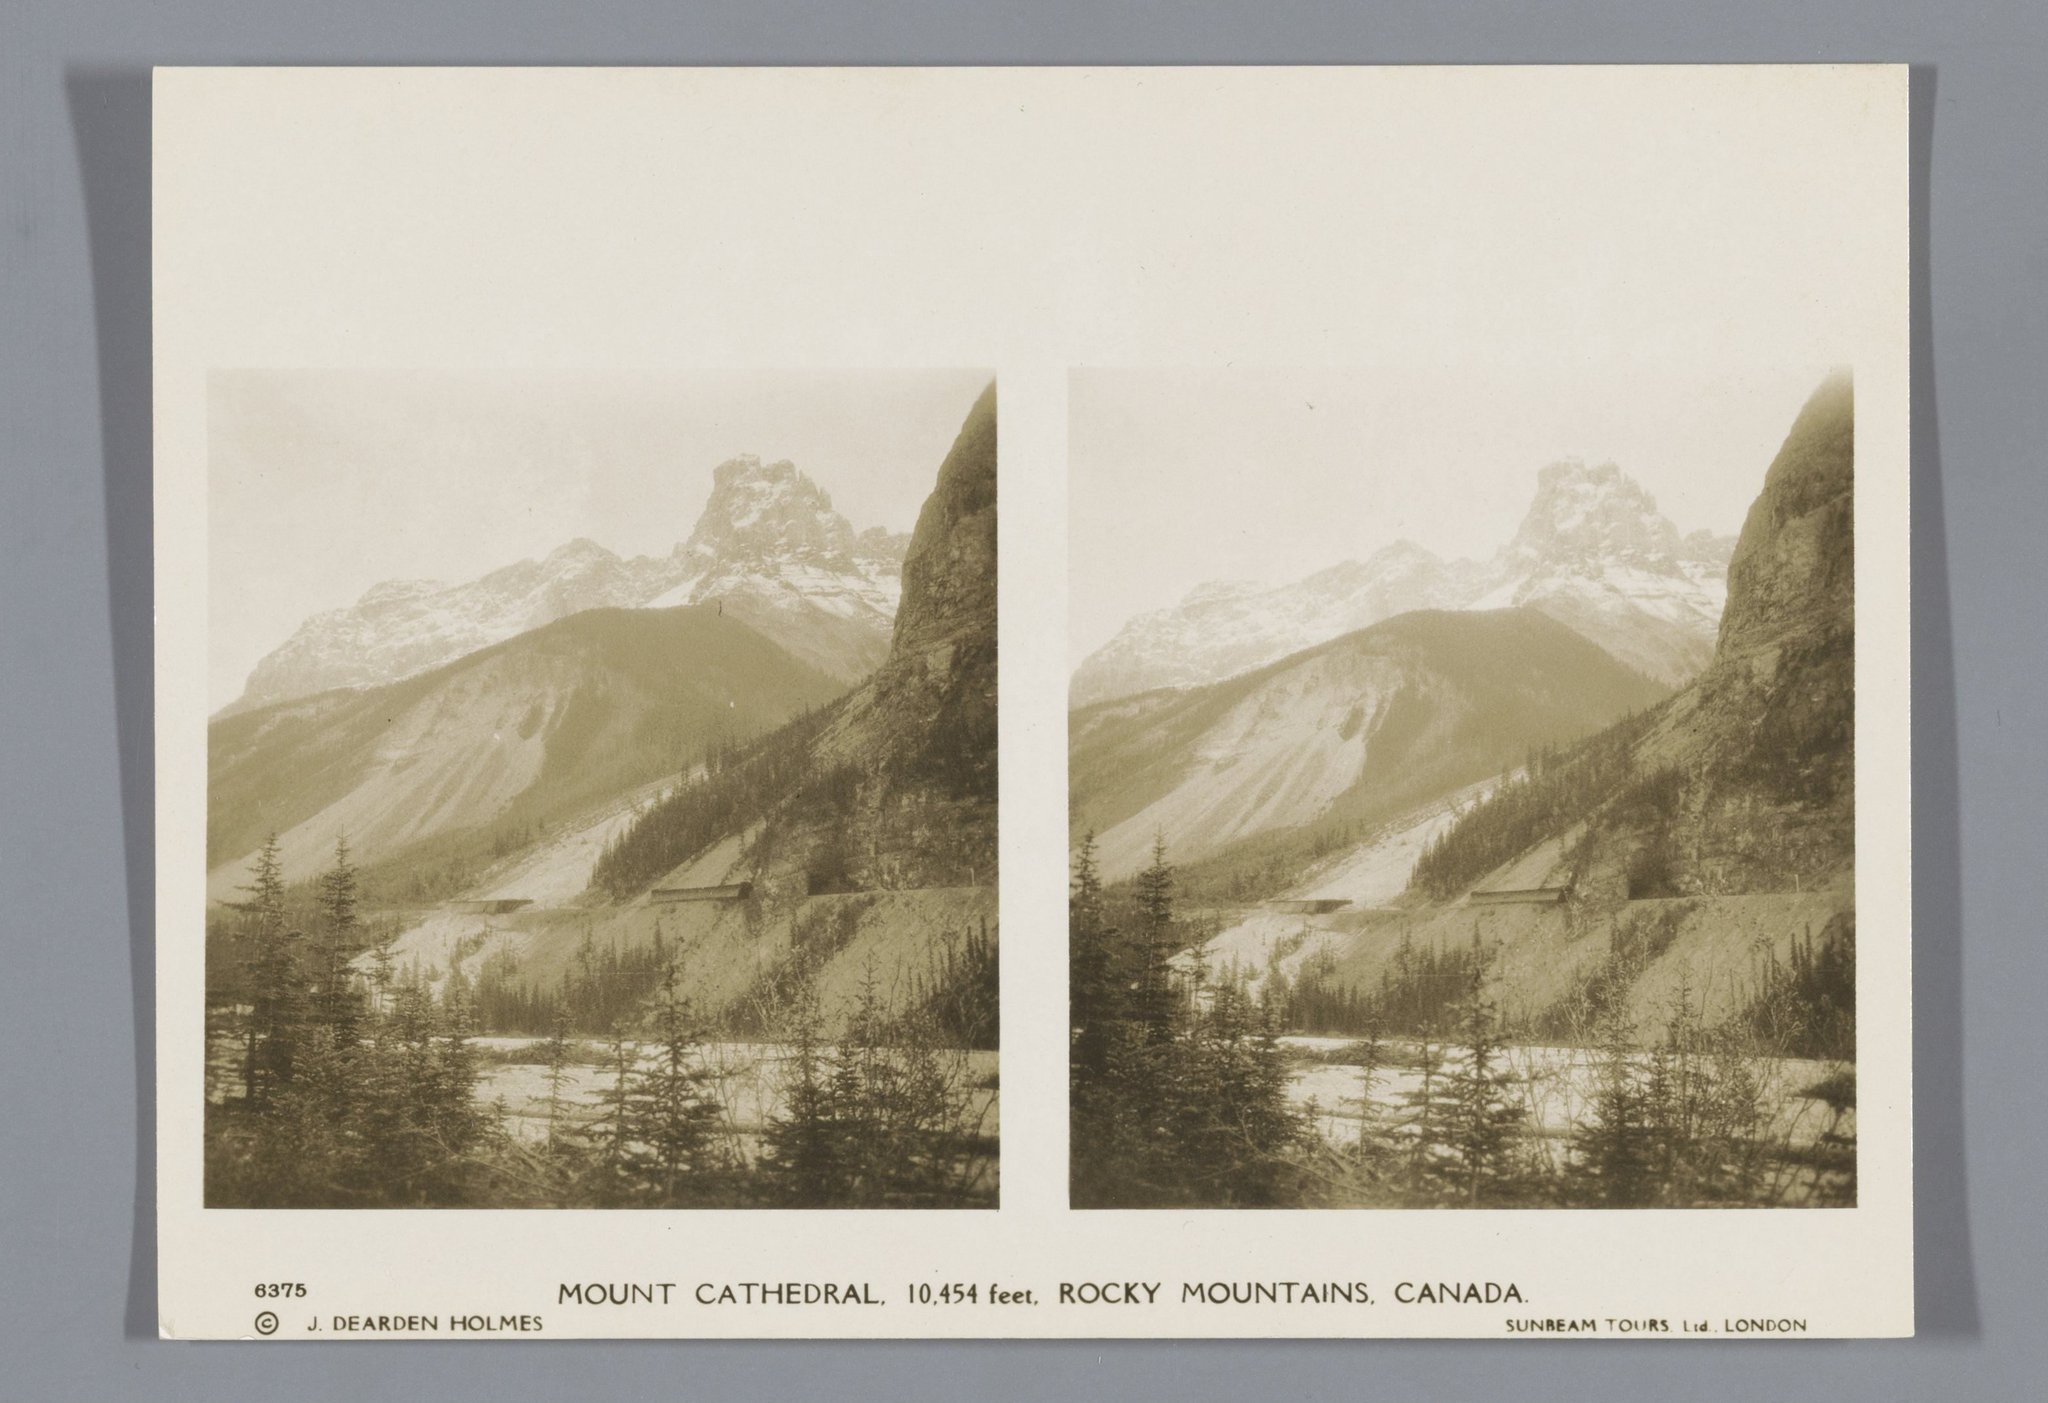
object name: stereograph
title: Mount Cathedral, 10,454 feet, Rocky Mountains, Canada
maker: james dearden holmes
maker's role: fotograaf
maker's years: 1873-1937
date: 1924-1926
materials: paper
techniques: gelatin silver print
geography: rocky mountains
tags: mountain-range, snow peaks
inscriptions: number: ‘6375’